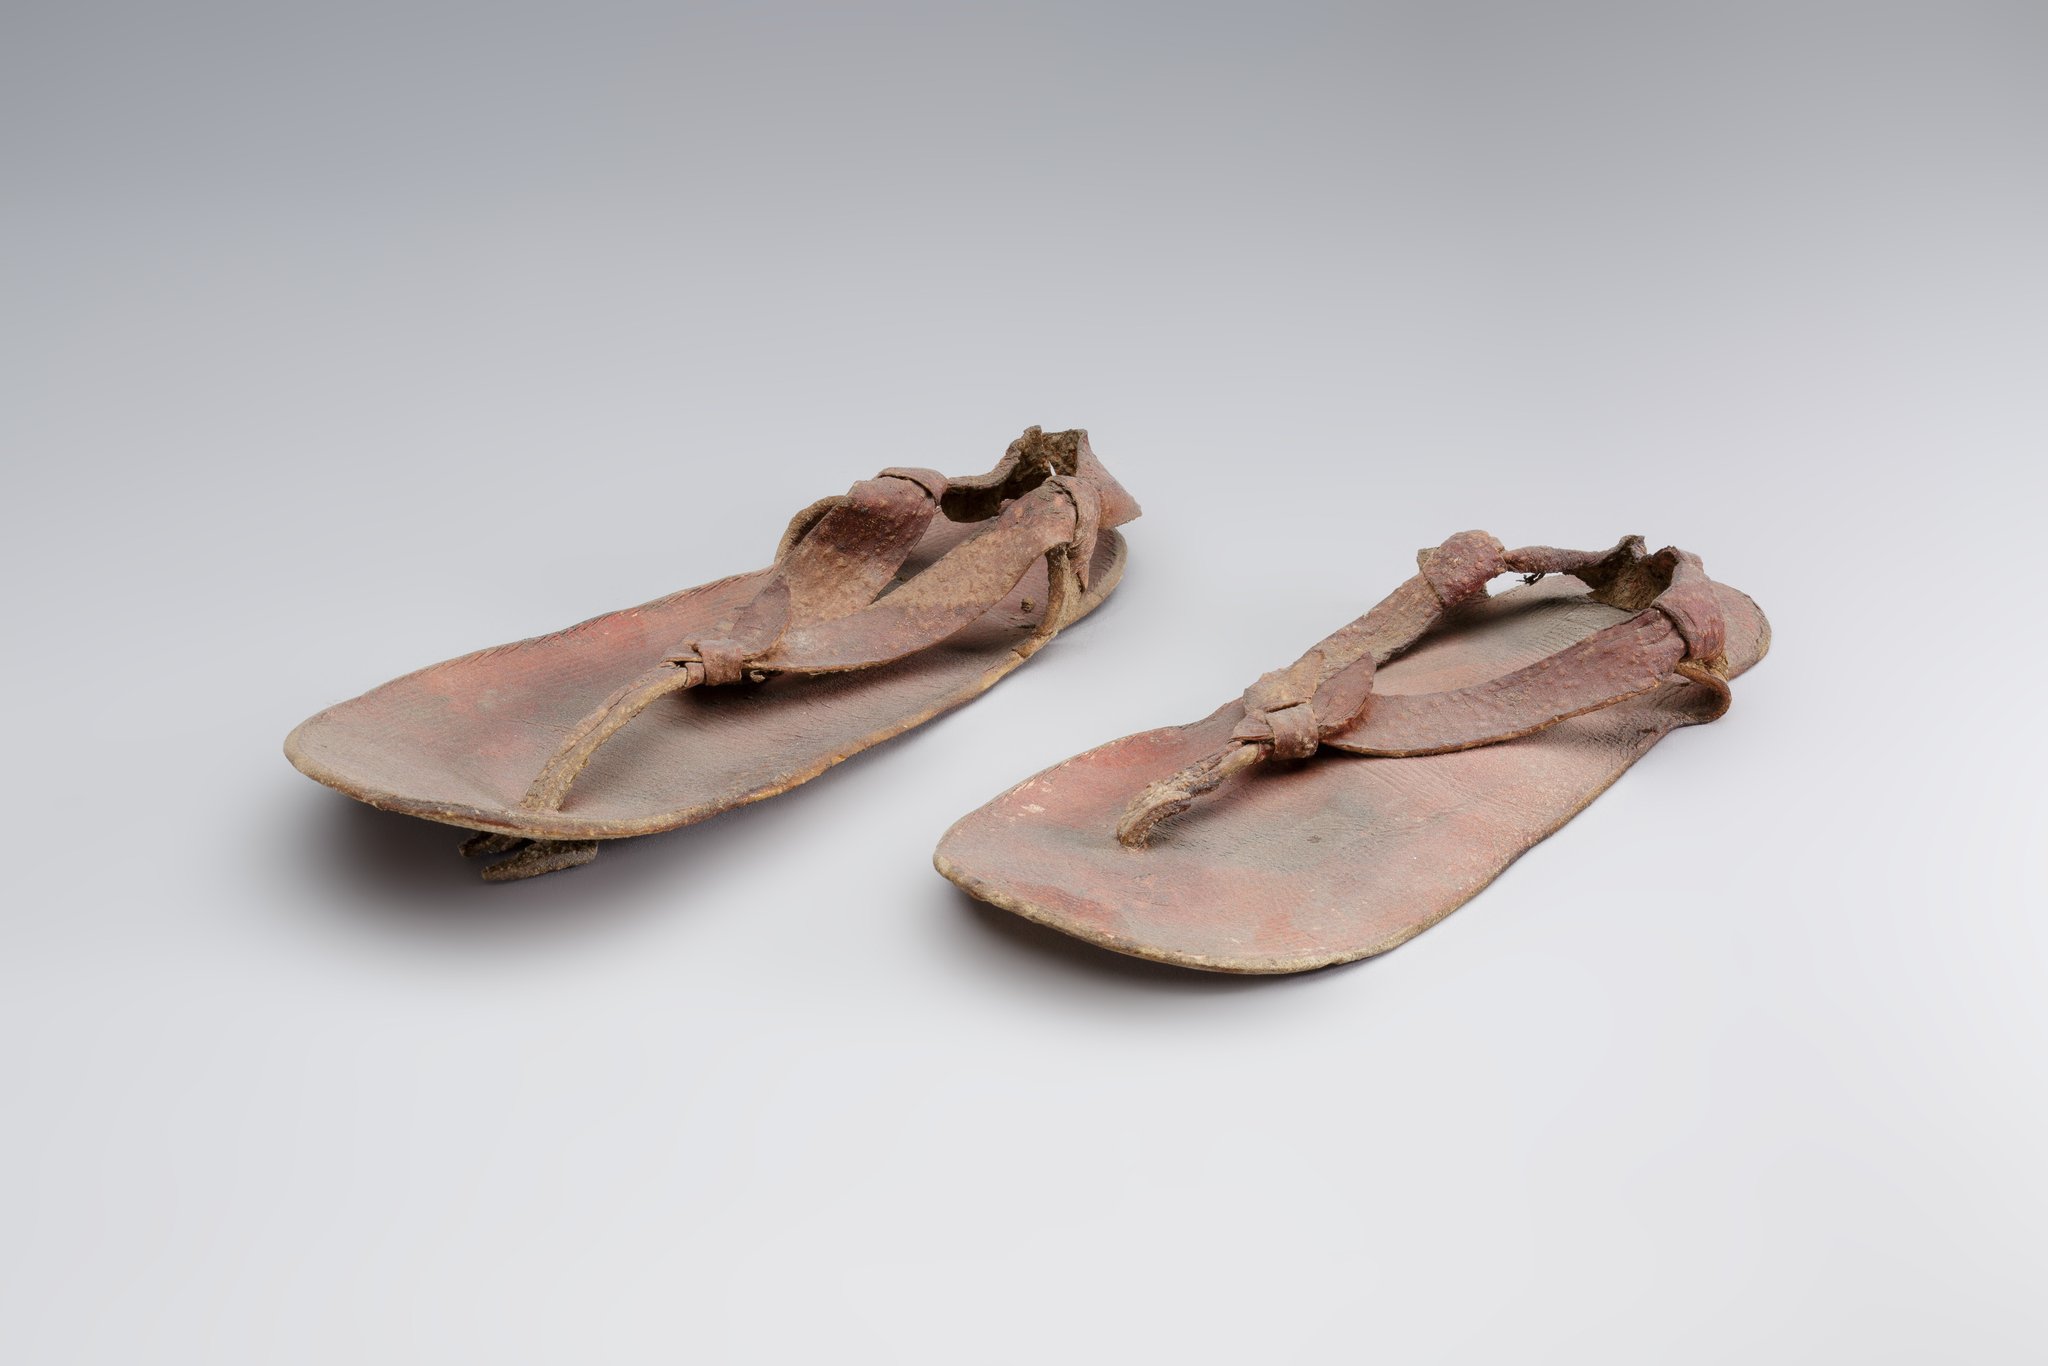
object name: sandal, leather, amenhotep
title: Pair of sandals from the Burial of Amenhotep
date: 1479-1458 BCE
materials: leather, skin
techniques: stain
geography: egypt